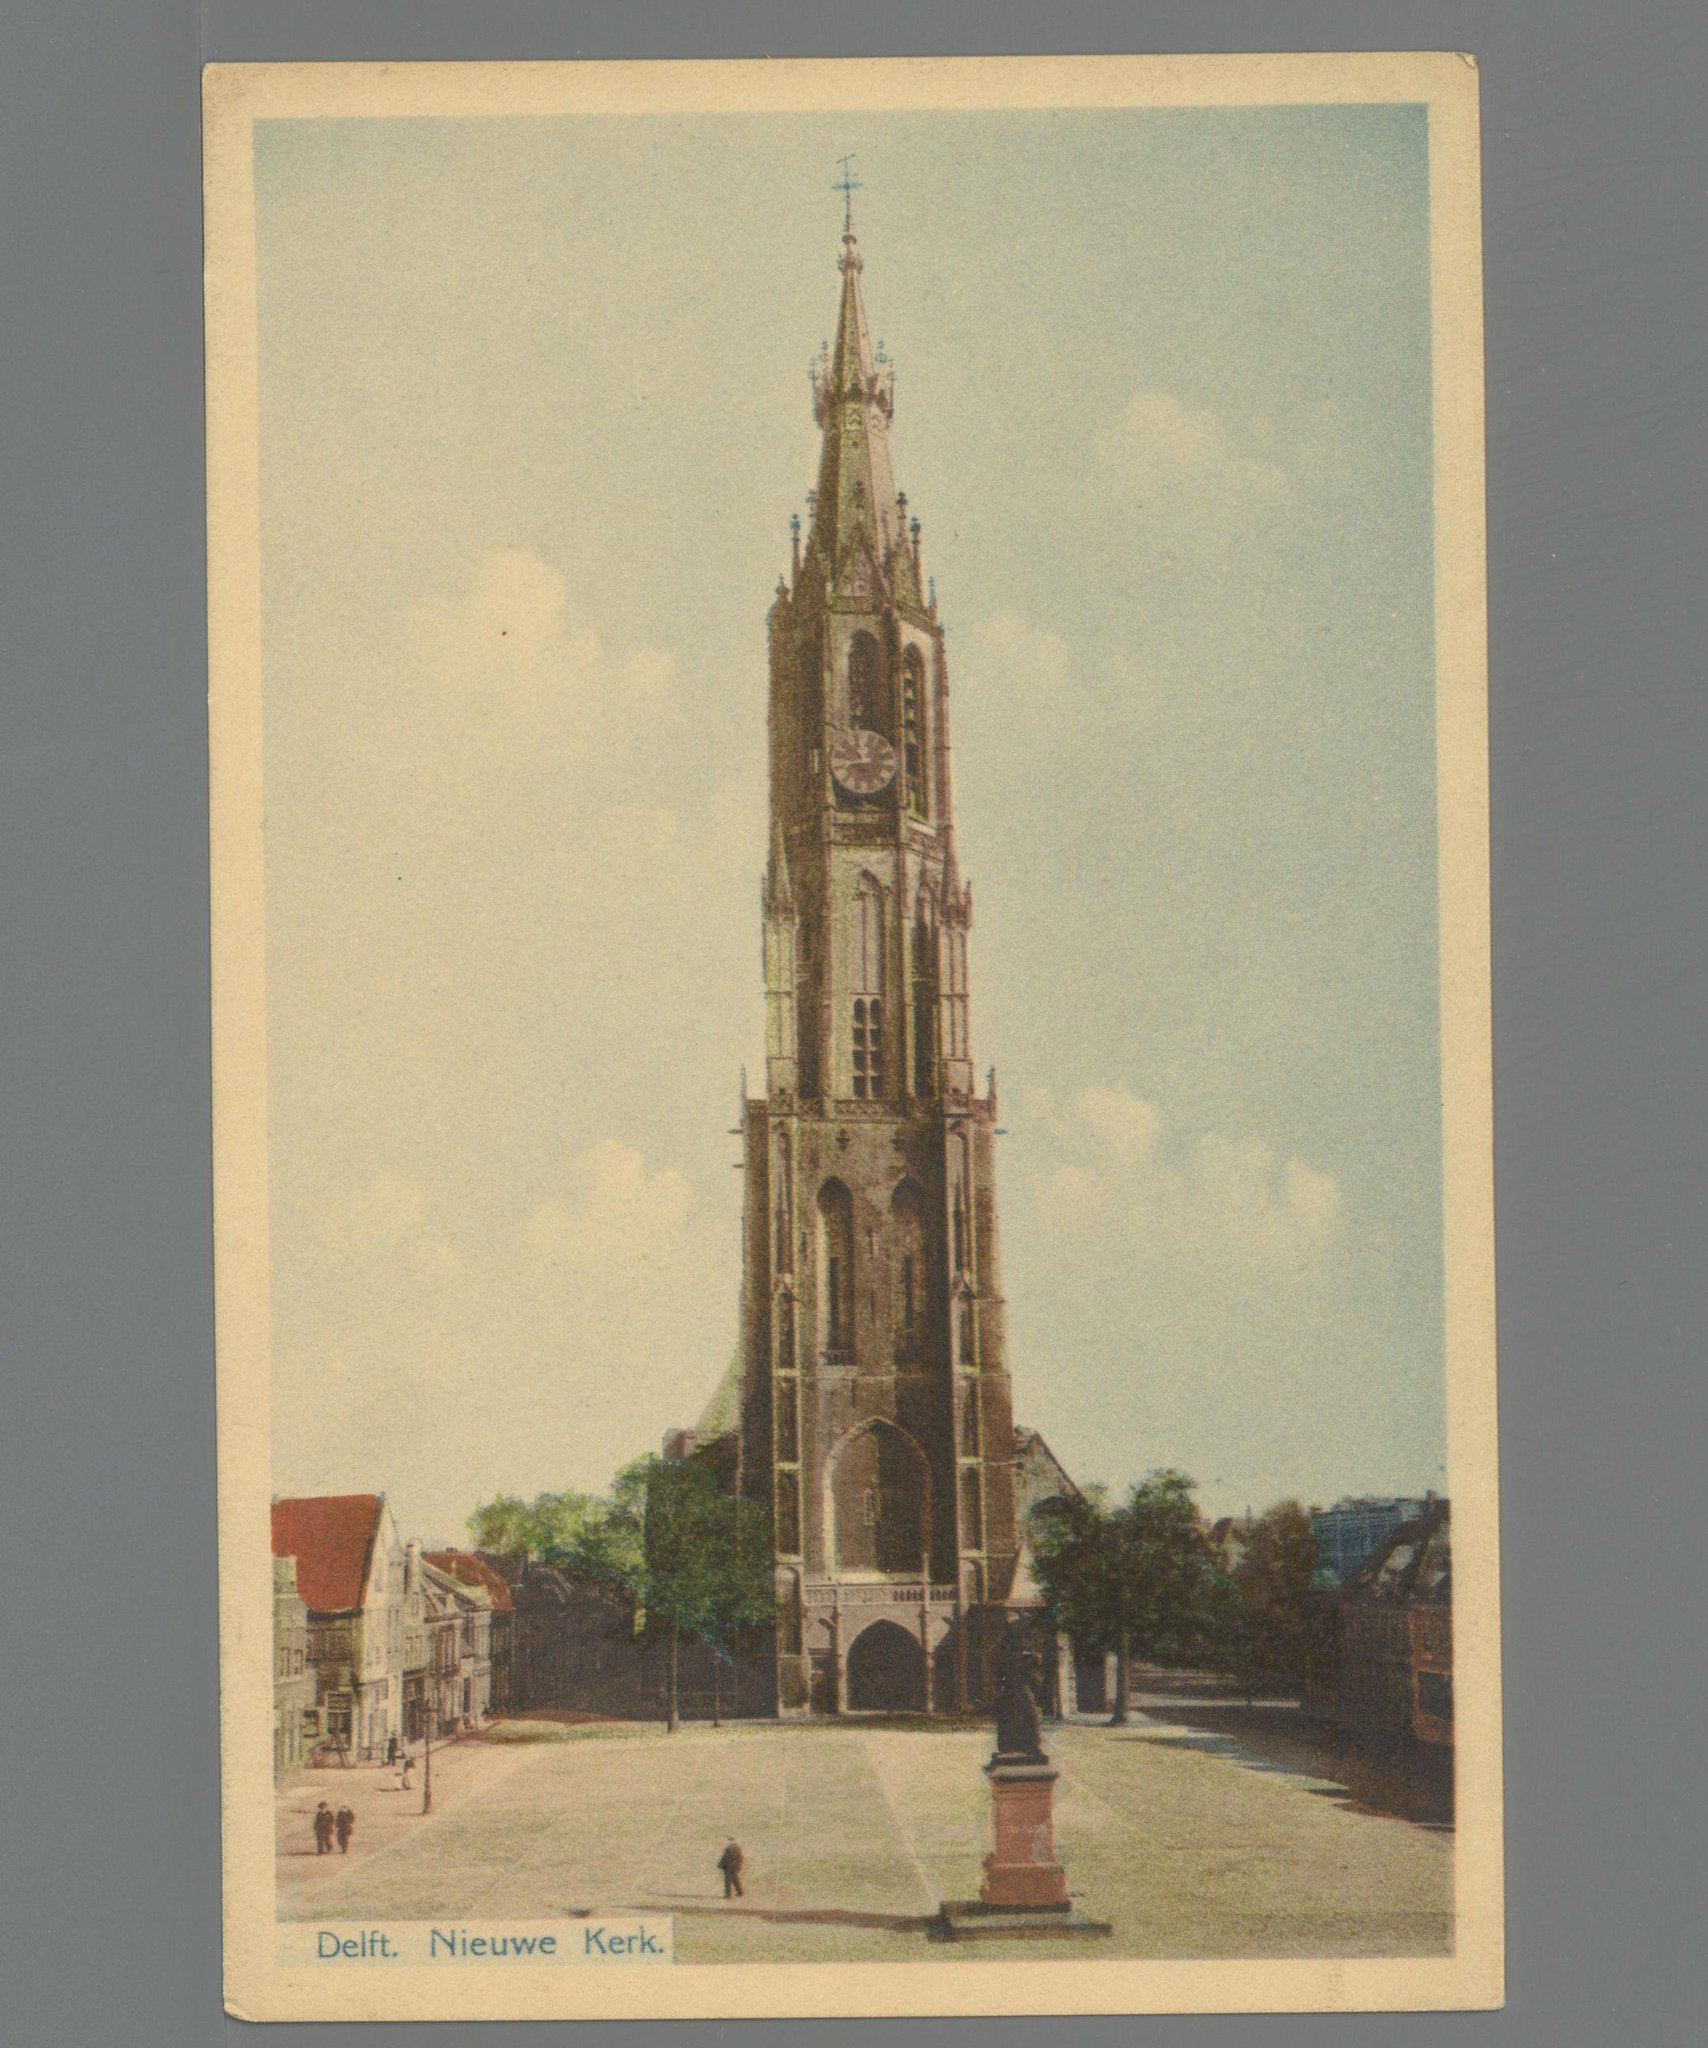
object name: ansichtkaart, prentbriefkaart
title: Delft. Nieuwe Kerk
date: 1911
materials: cardboard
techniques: collotype process, lithograph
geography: delft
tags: delft, hugo de groot, church (exterior), monument, statue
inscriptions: date